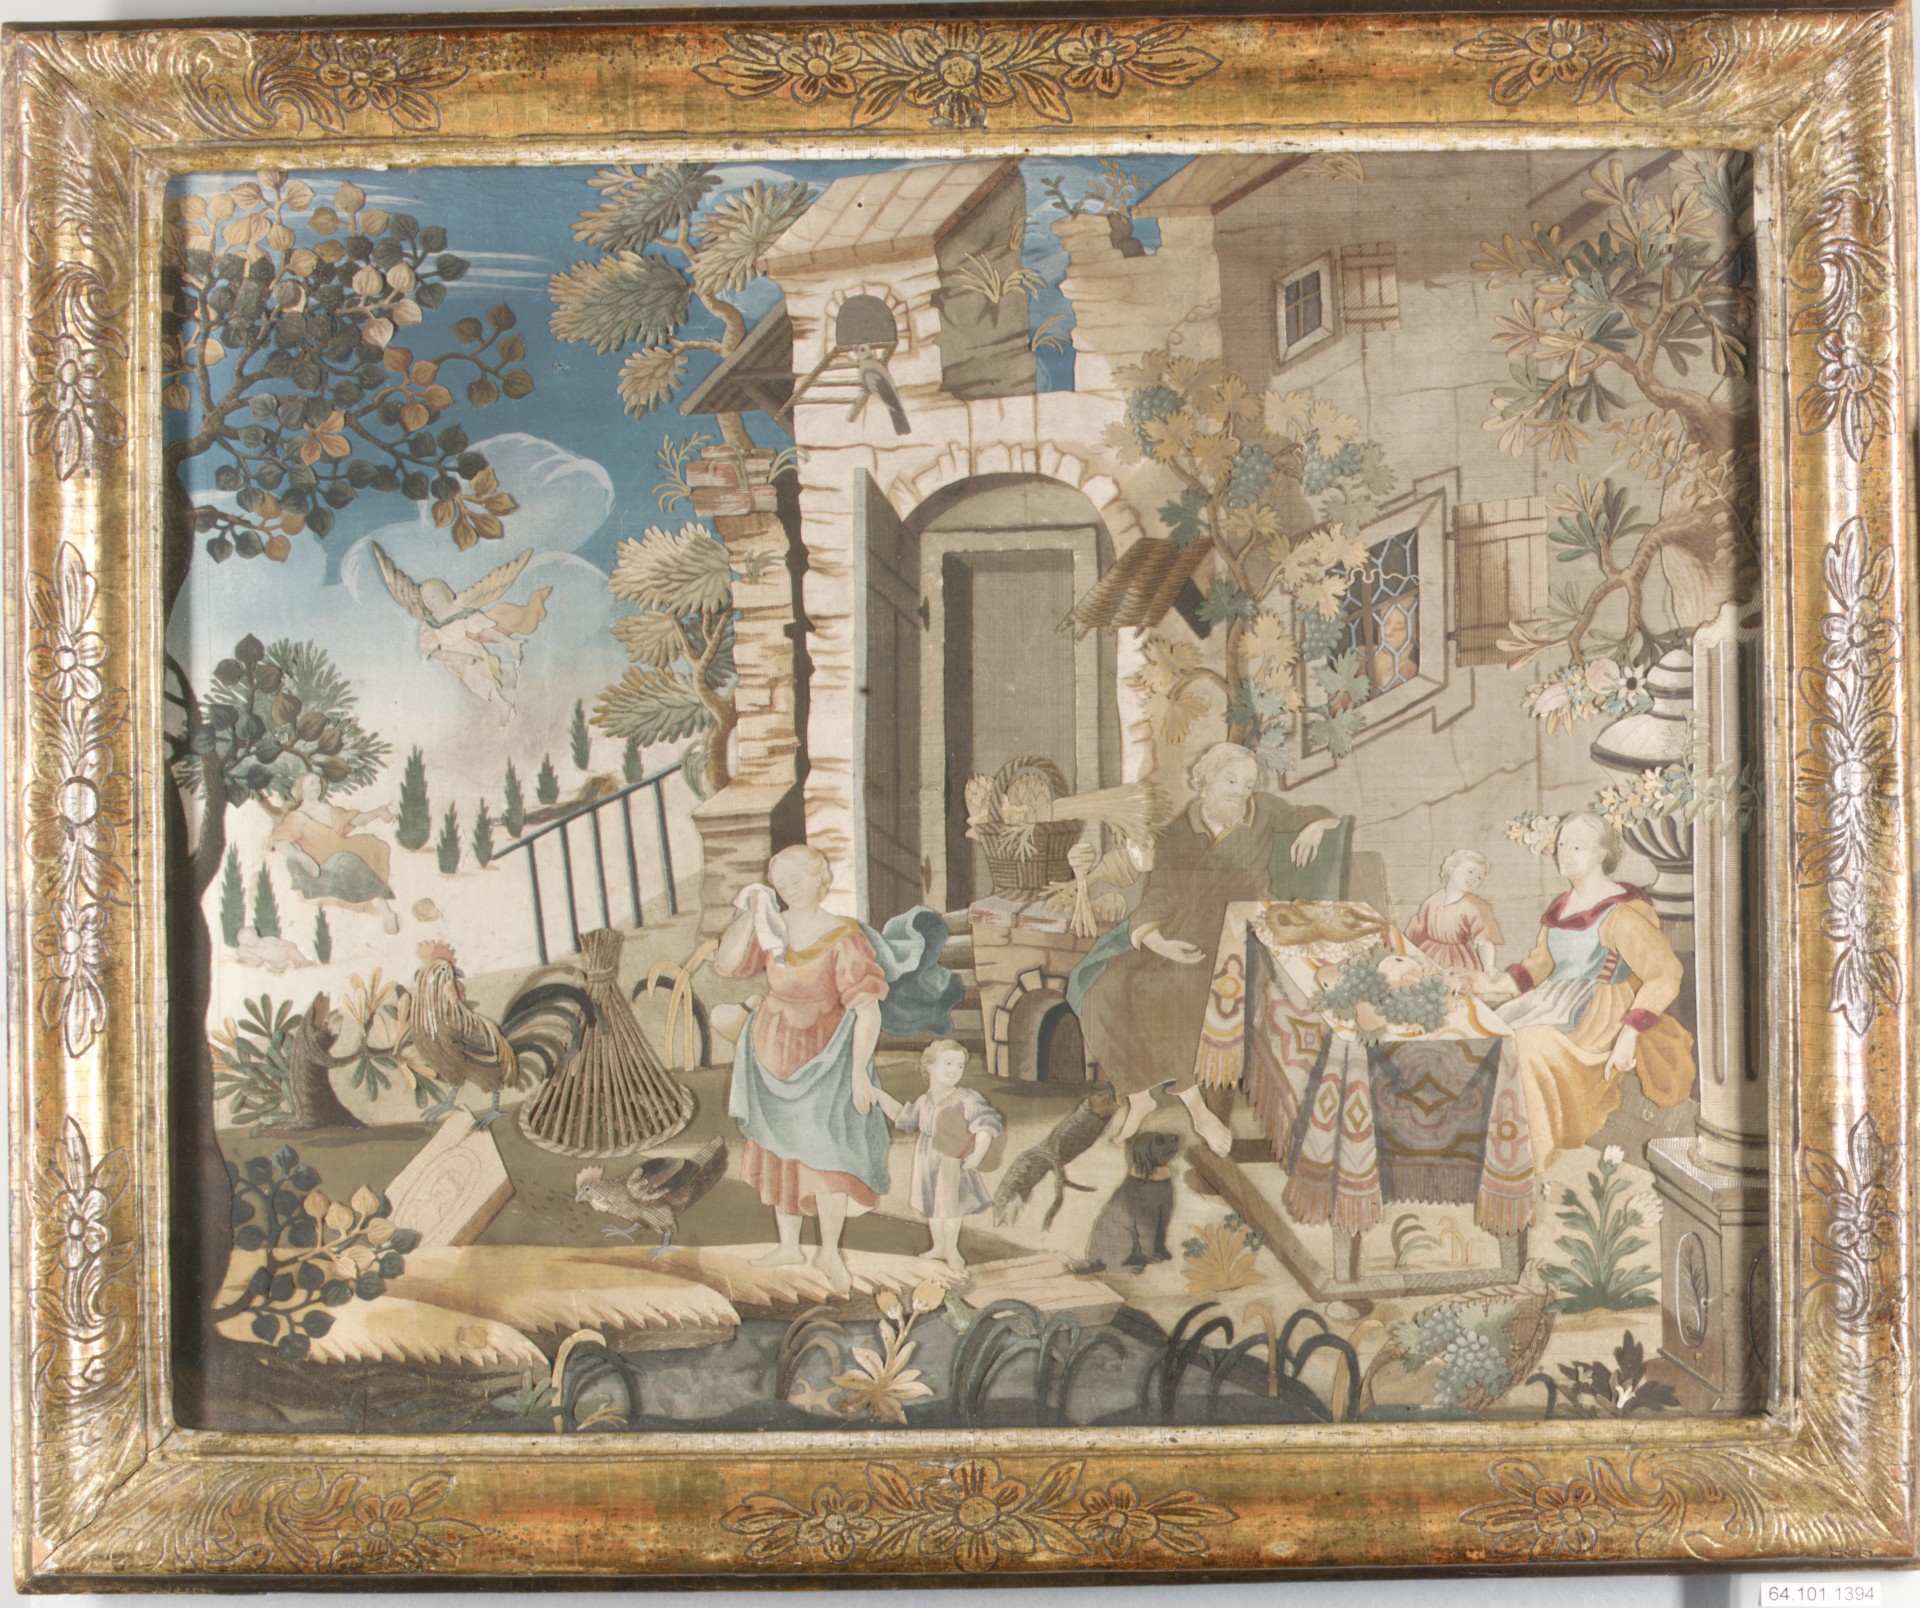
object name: embroidered picture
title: Collage picture with scenes from the Story of Abraham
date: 1776-1800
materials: paper, silk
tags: houses,children,men,women,roosters,dogs,abraham